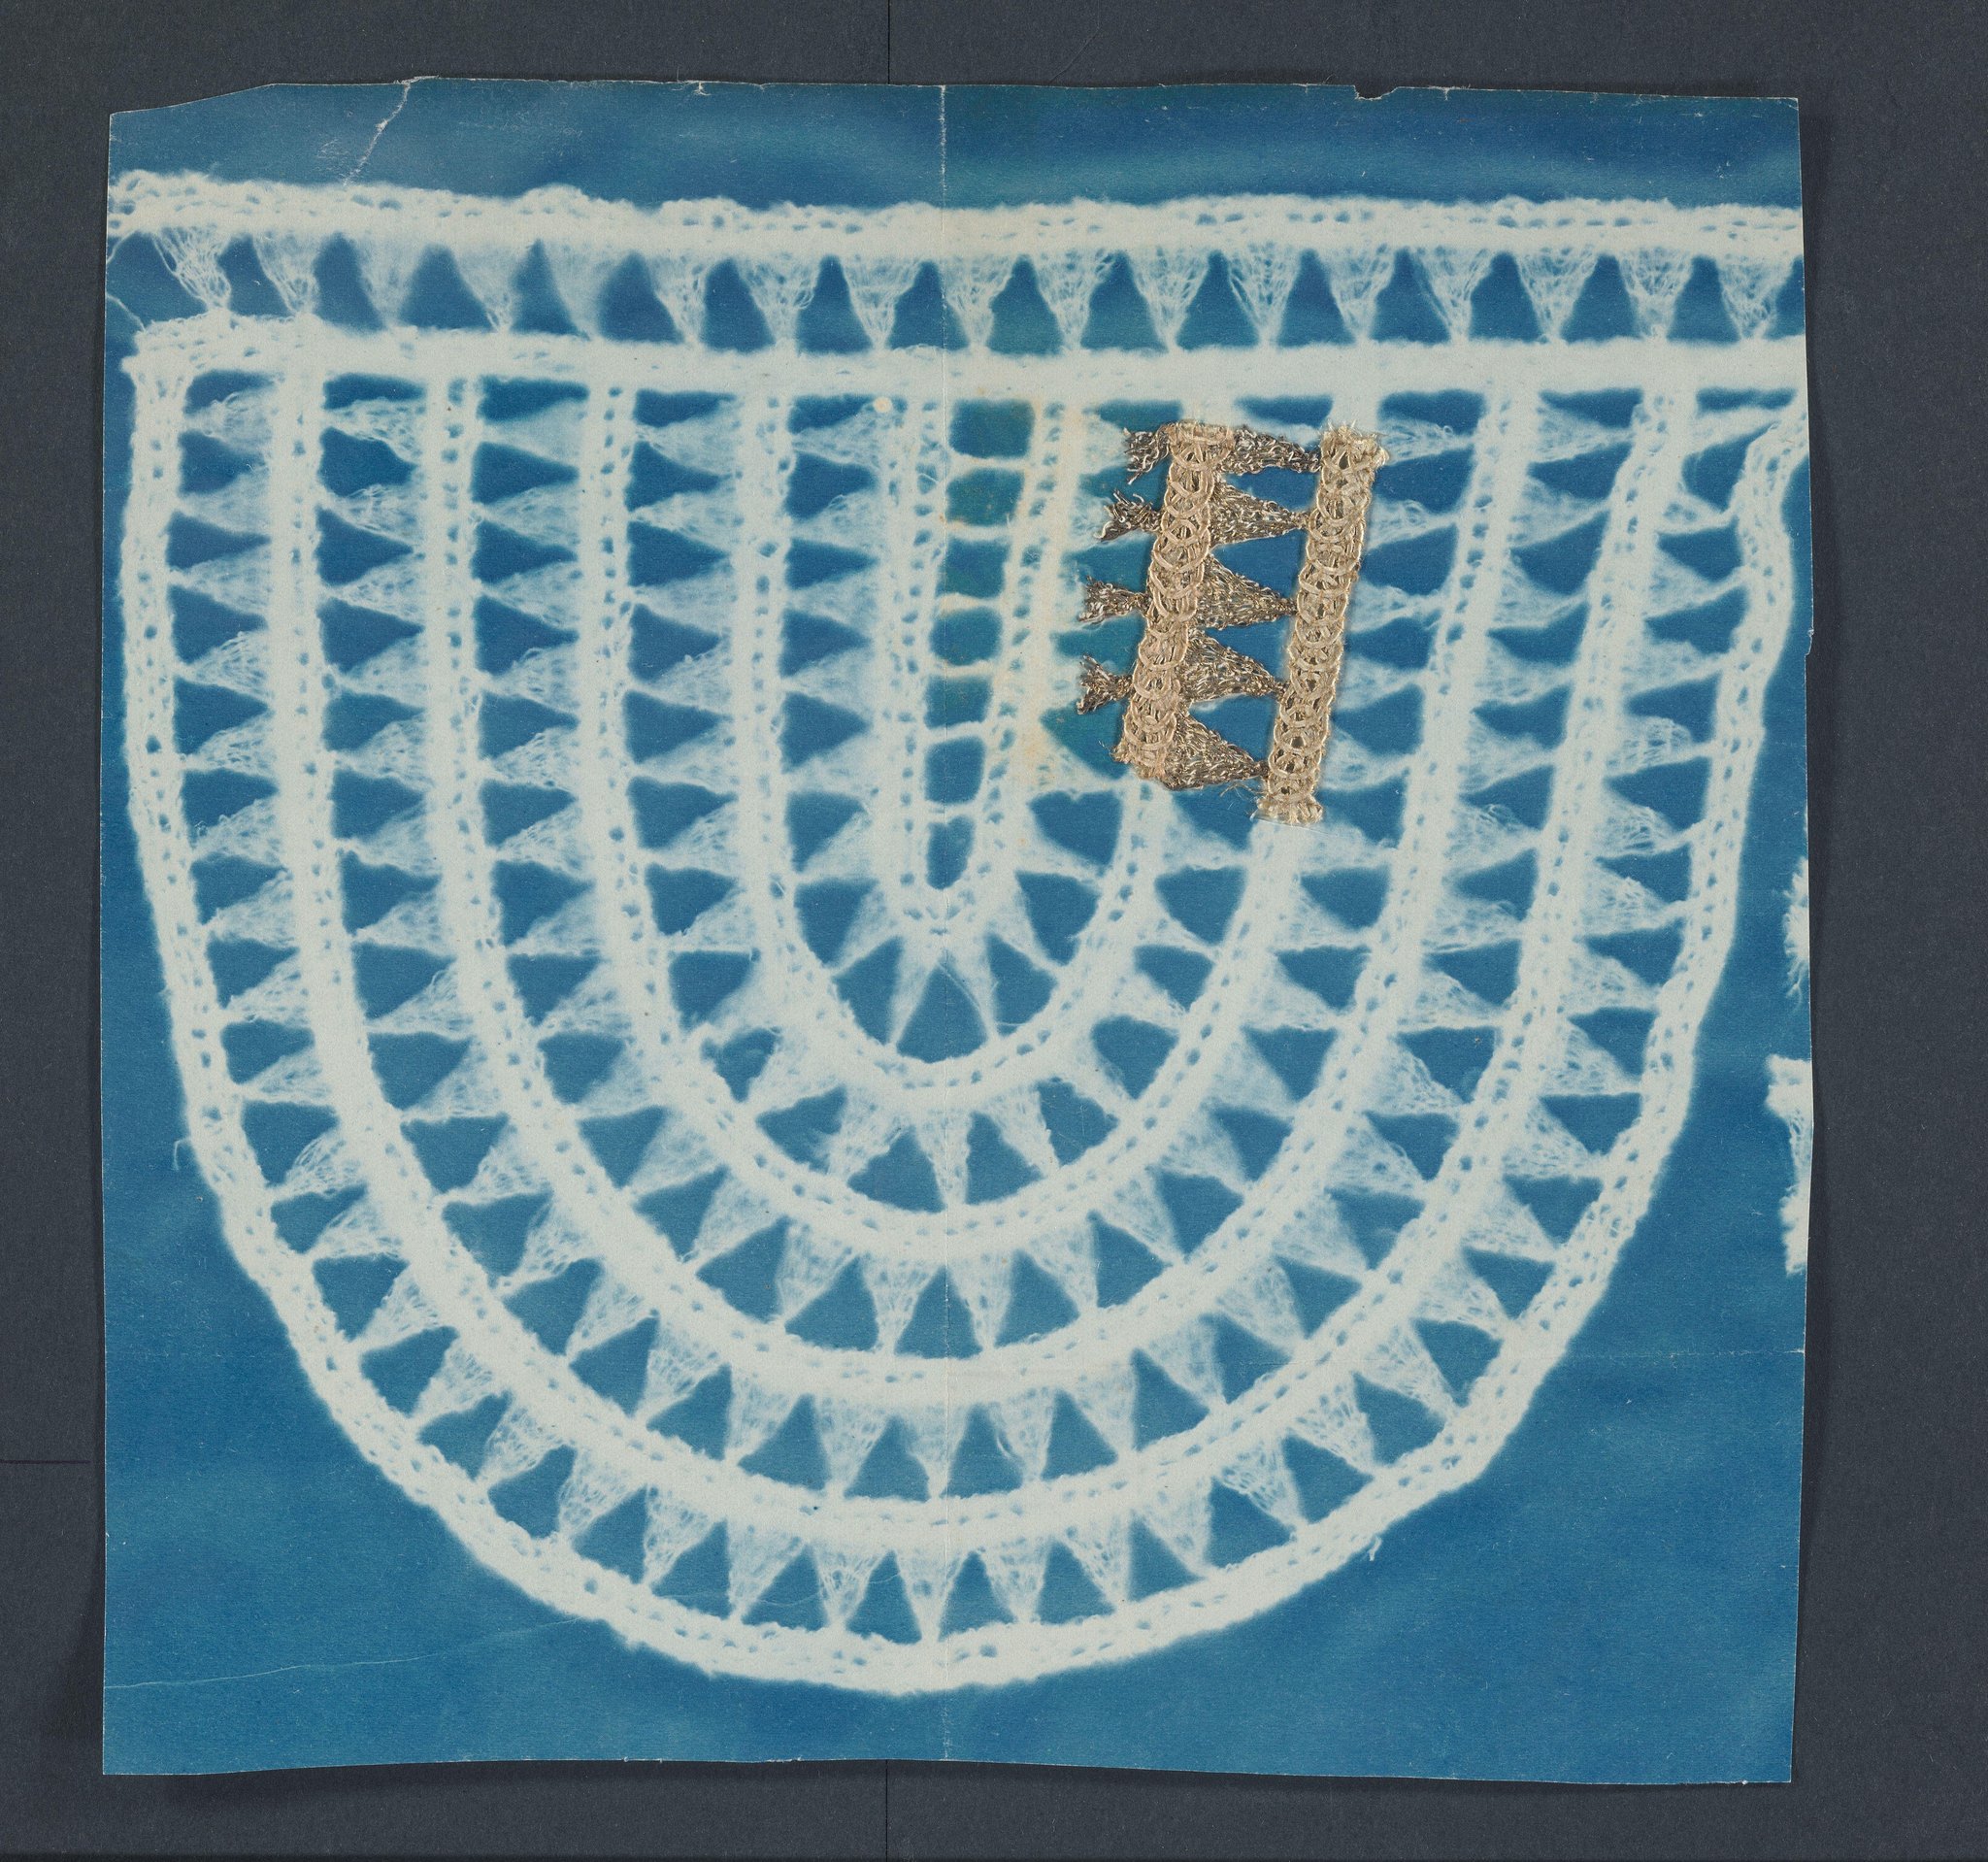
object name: photogram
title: Kant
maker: Anonymous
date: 1900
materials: metal, paper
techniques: cyanotype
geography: france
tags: lace